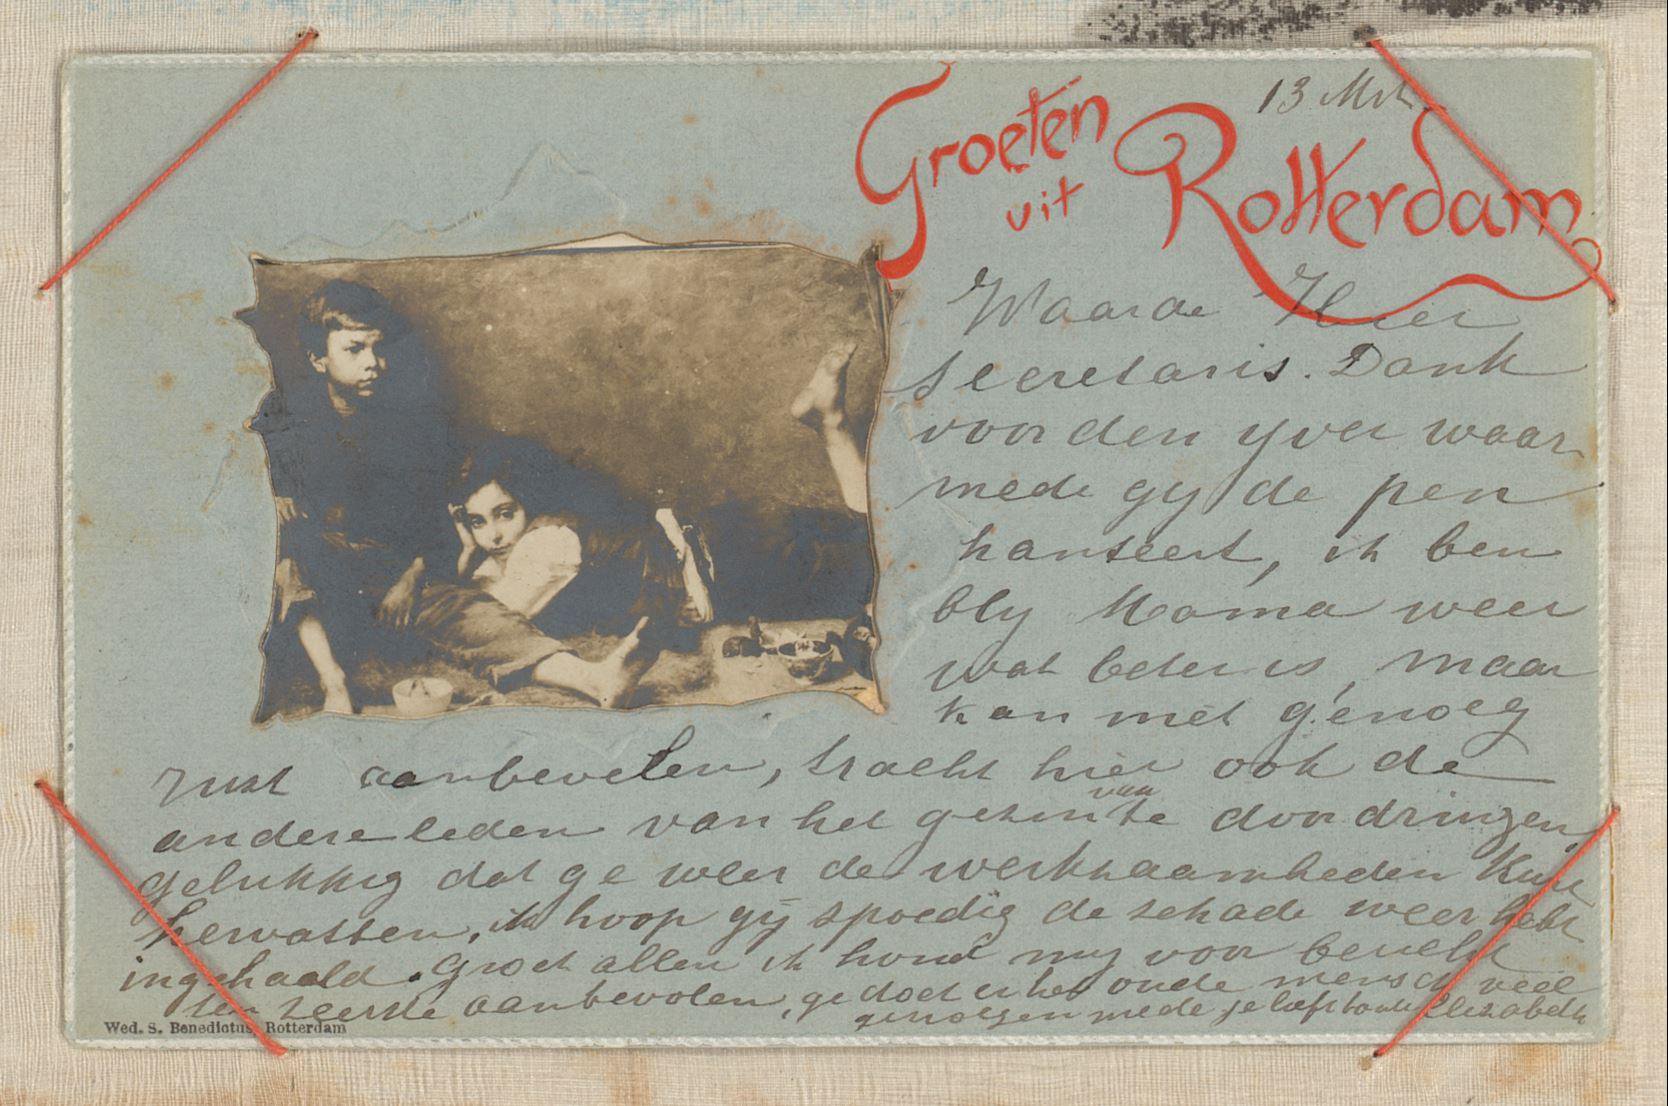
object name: album leaf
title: Portret van een jongen en een jonge vrouw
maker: Anonymous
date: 1880-1910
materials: cardboard, paint, photographic support, silk, textile, watercolor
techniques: blind stamped, brush, gelatin silver print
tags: adolescent, young woman, maiden, boy (child between toddler and youth), historical persons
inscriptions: annotation: ‘13 Mei/ Waarde Heer/ (...)’